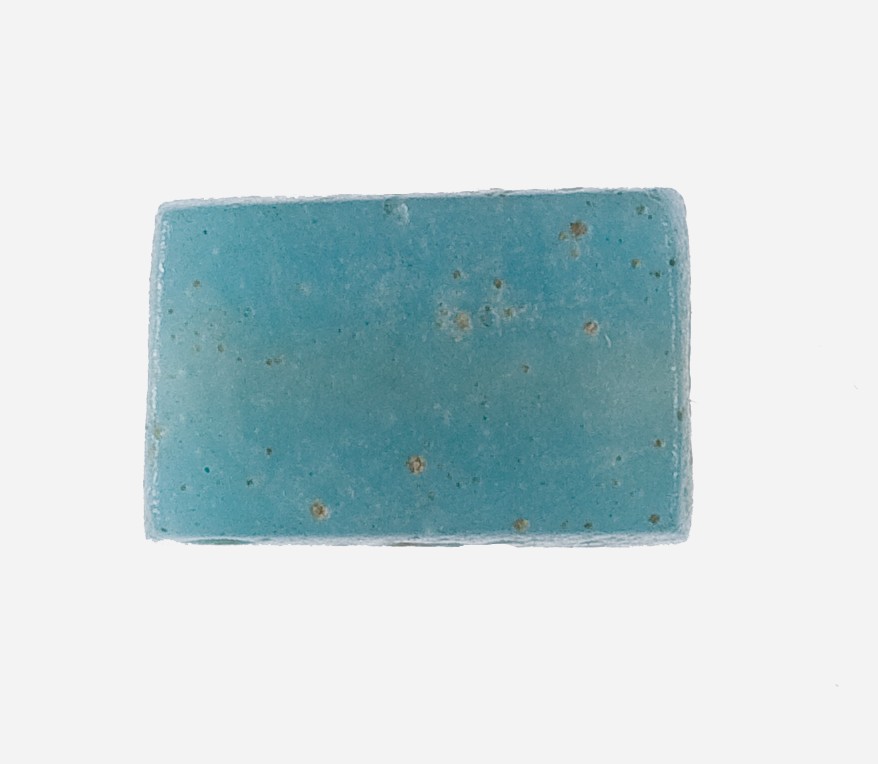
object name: foundation deposit plaque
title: Plaque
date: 1390-1352 BCE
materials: glass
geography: egypt